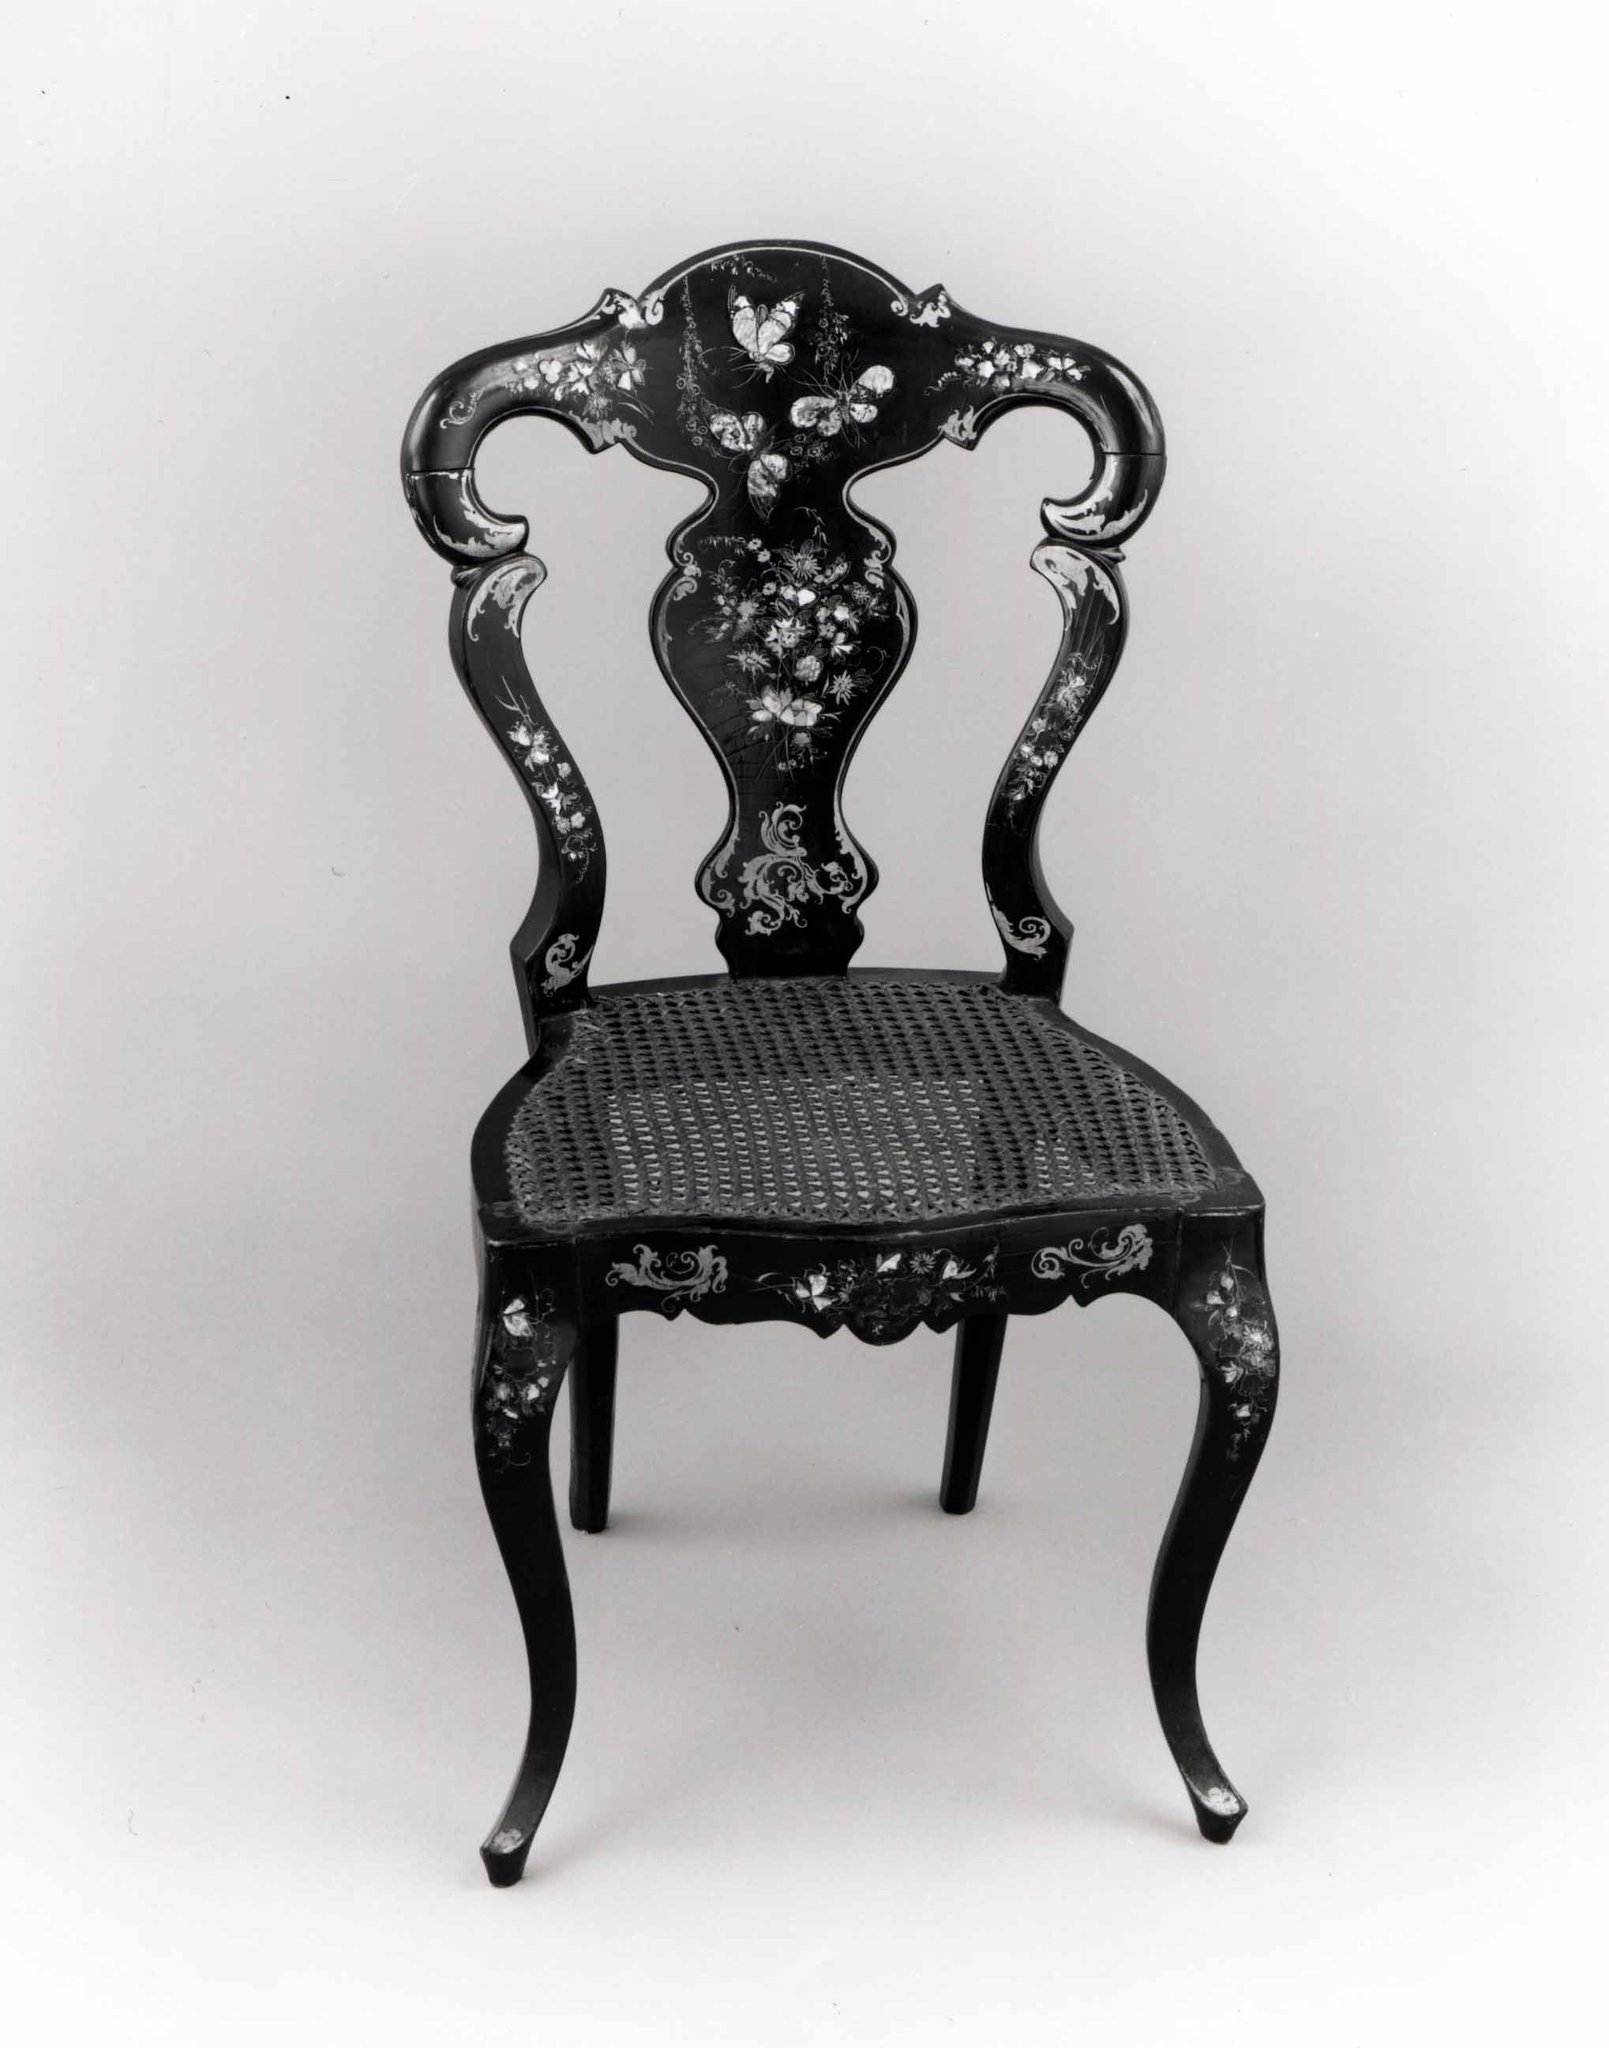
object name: chair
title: Papier-mâché side chair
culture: british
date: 1830-1860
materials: lacquer, mother of pearl, paper, wood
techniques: caning, gilding, painting